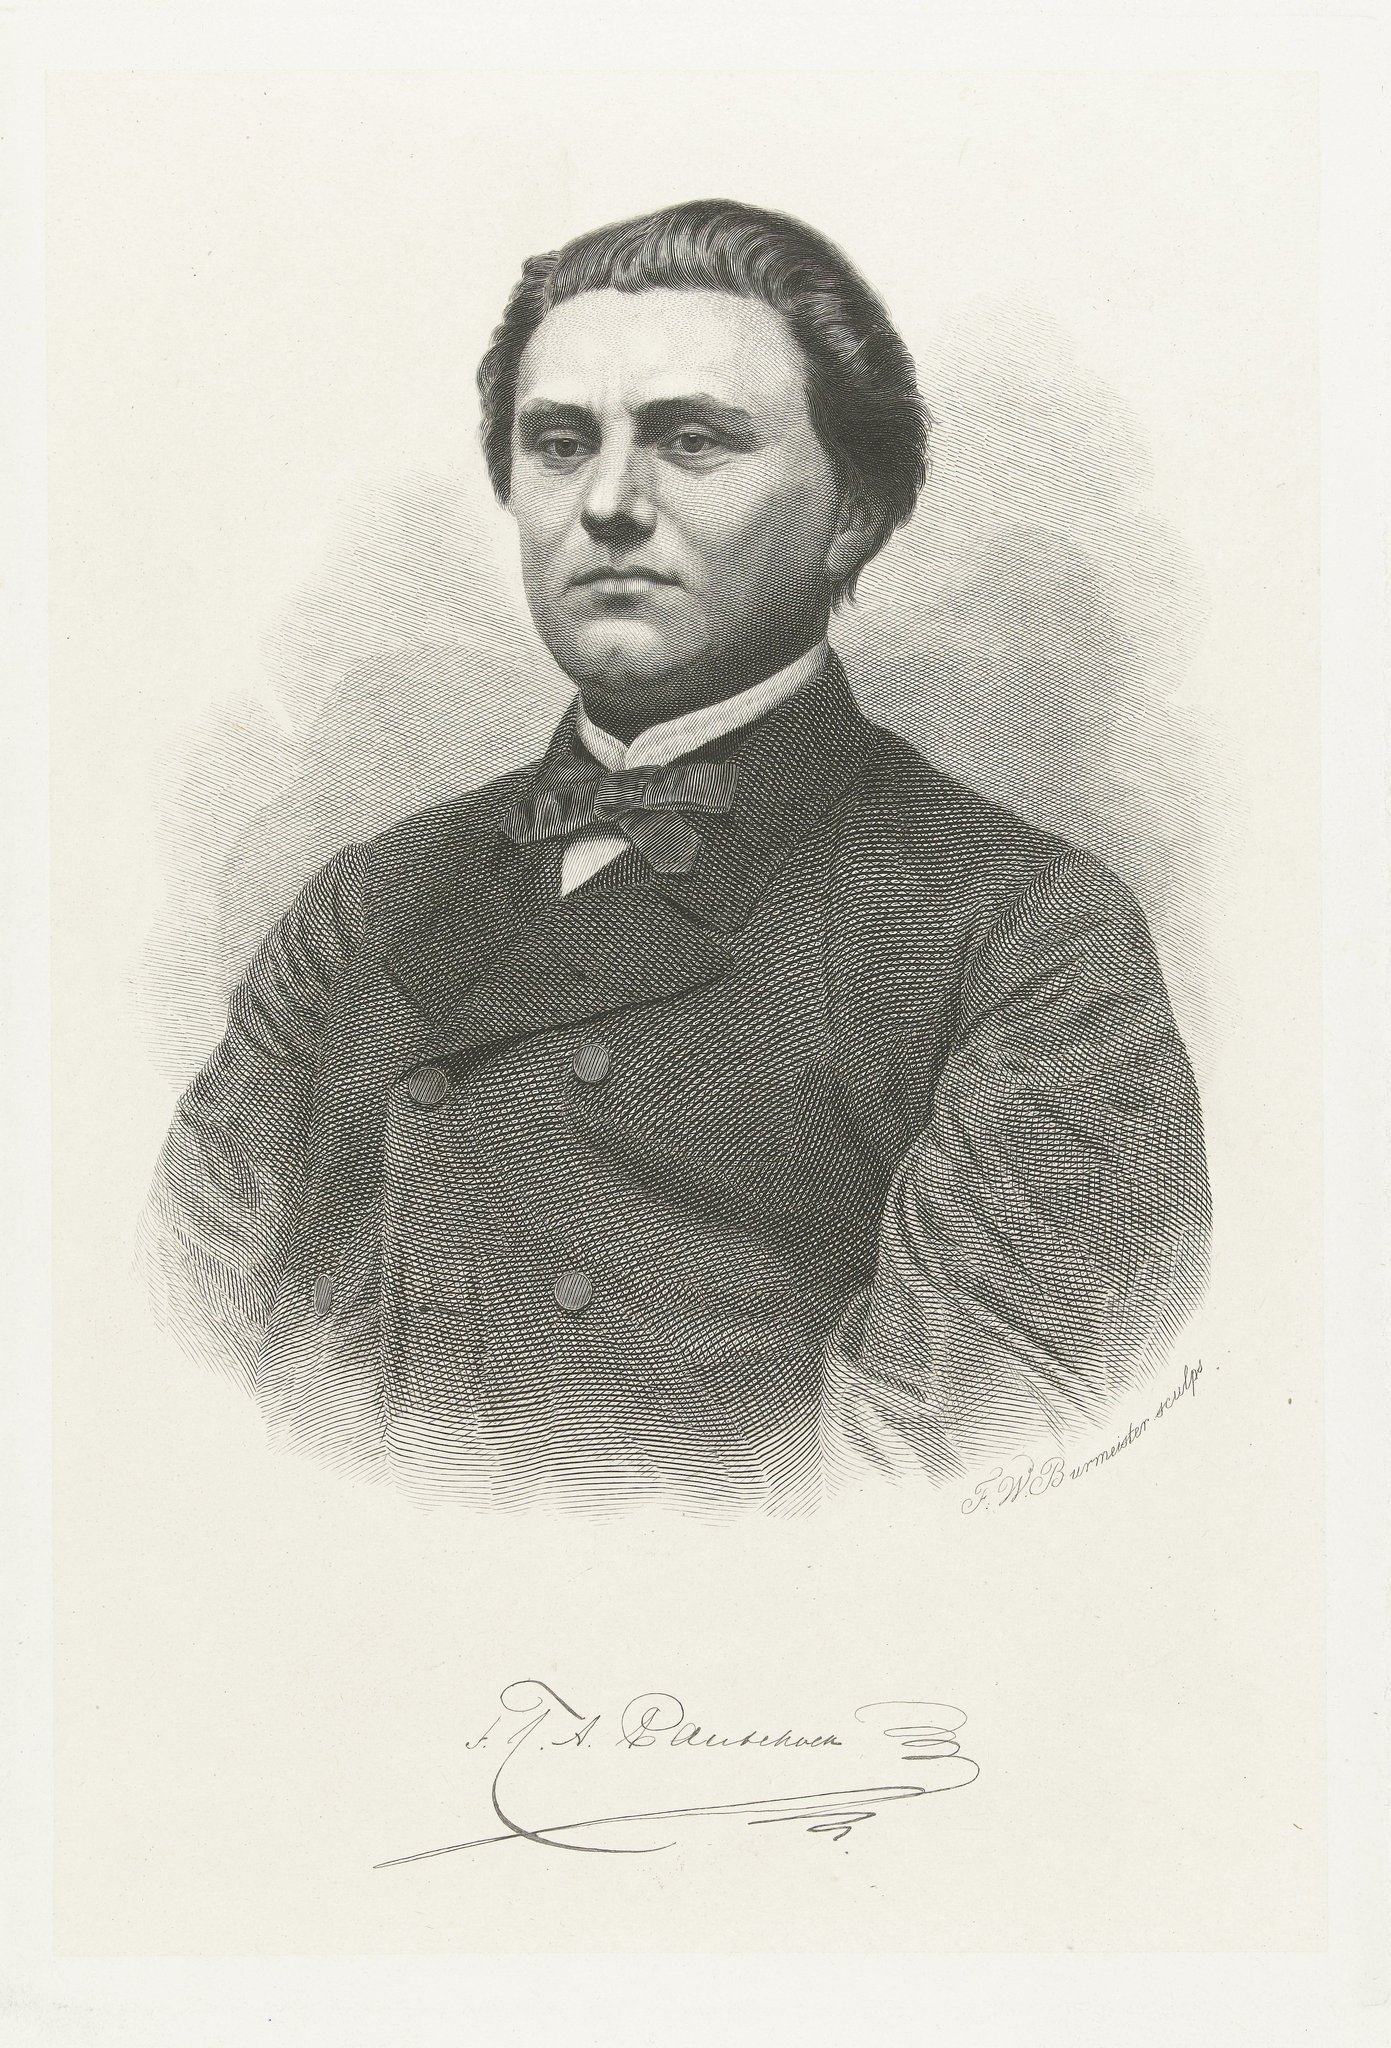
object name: print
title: Portret van Frederik Karel Antonius Pantekoek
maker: friedrich wilhelm burmeister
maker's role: print maker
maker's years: 1845-1933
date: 1855-1898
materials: paper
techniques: engraving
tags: historical persons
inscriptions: collector's mark: Lugt 2228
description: Portret in ovale lijst van F.C.A. Pantekoek, een Amsterdamse predikant. Buste naar links. De man is gekleed in een net pak met strikdas. Met de handtekening van de geportretteerde.